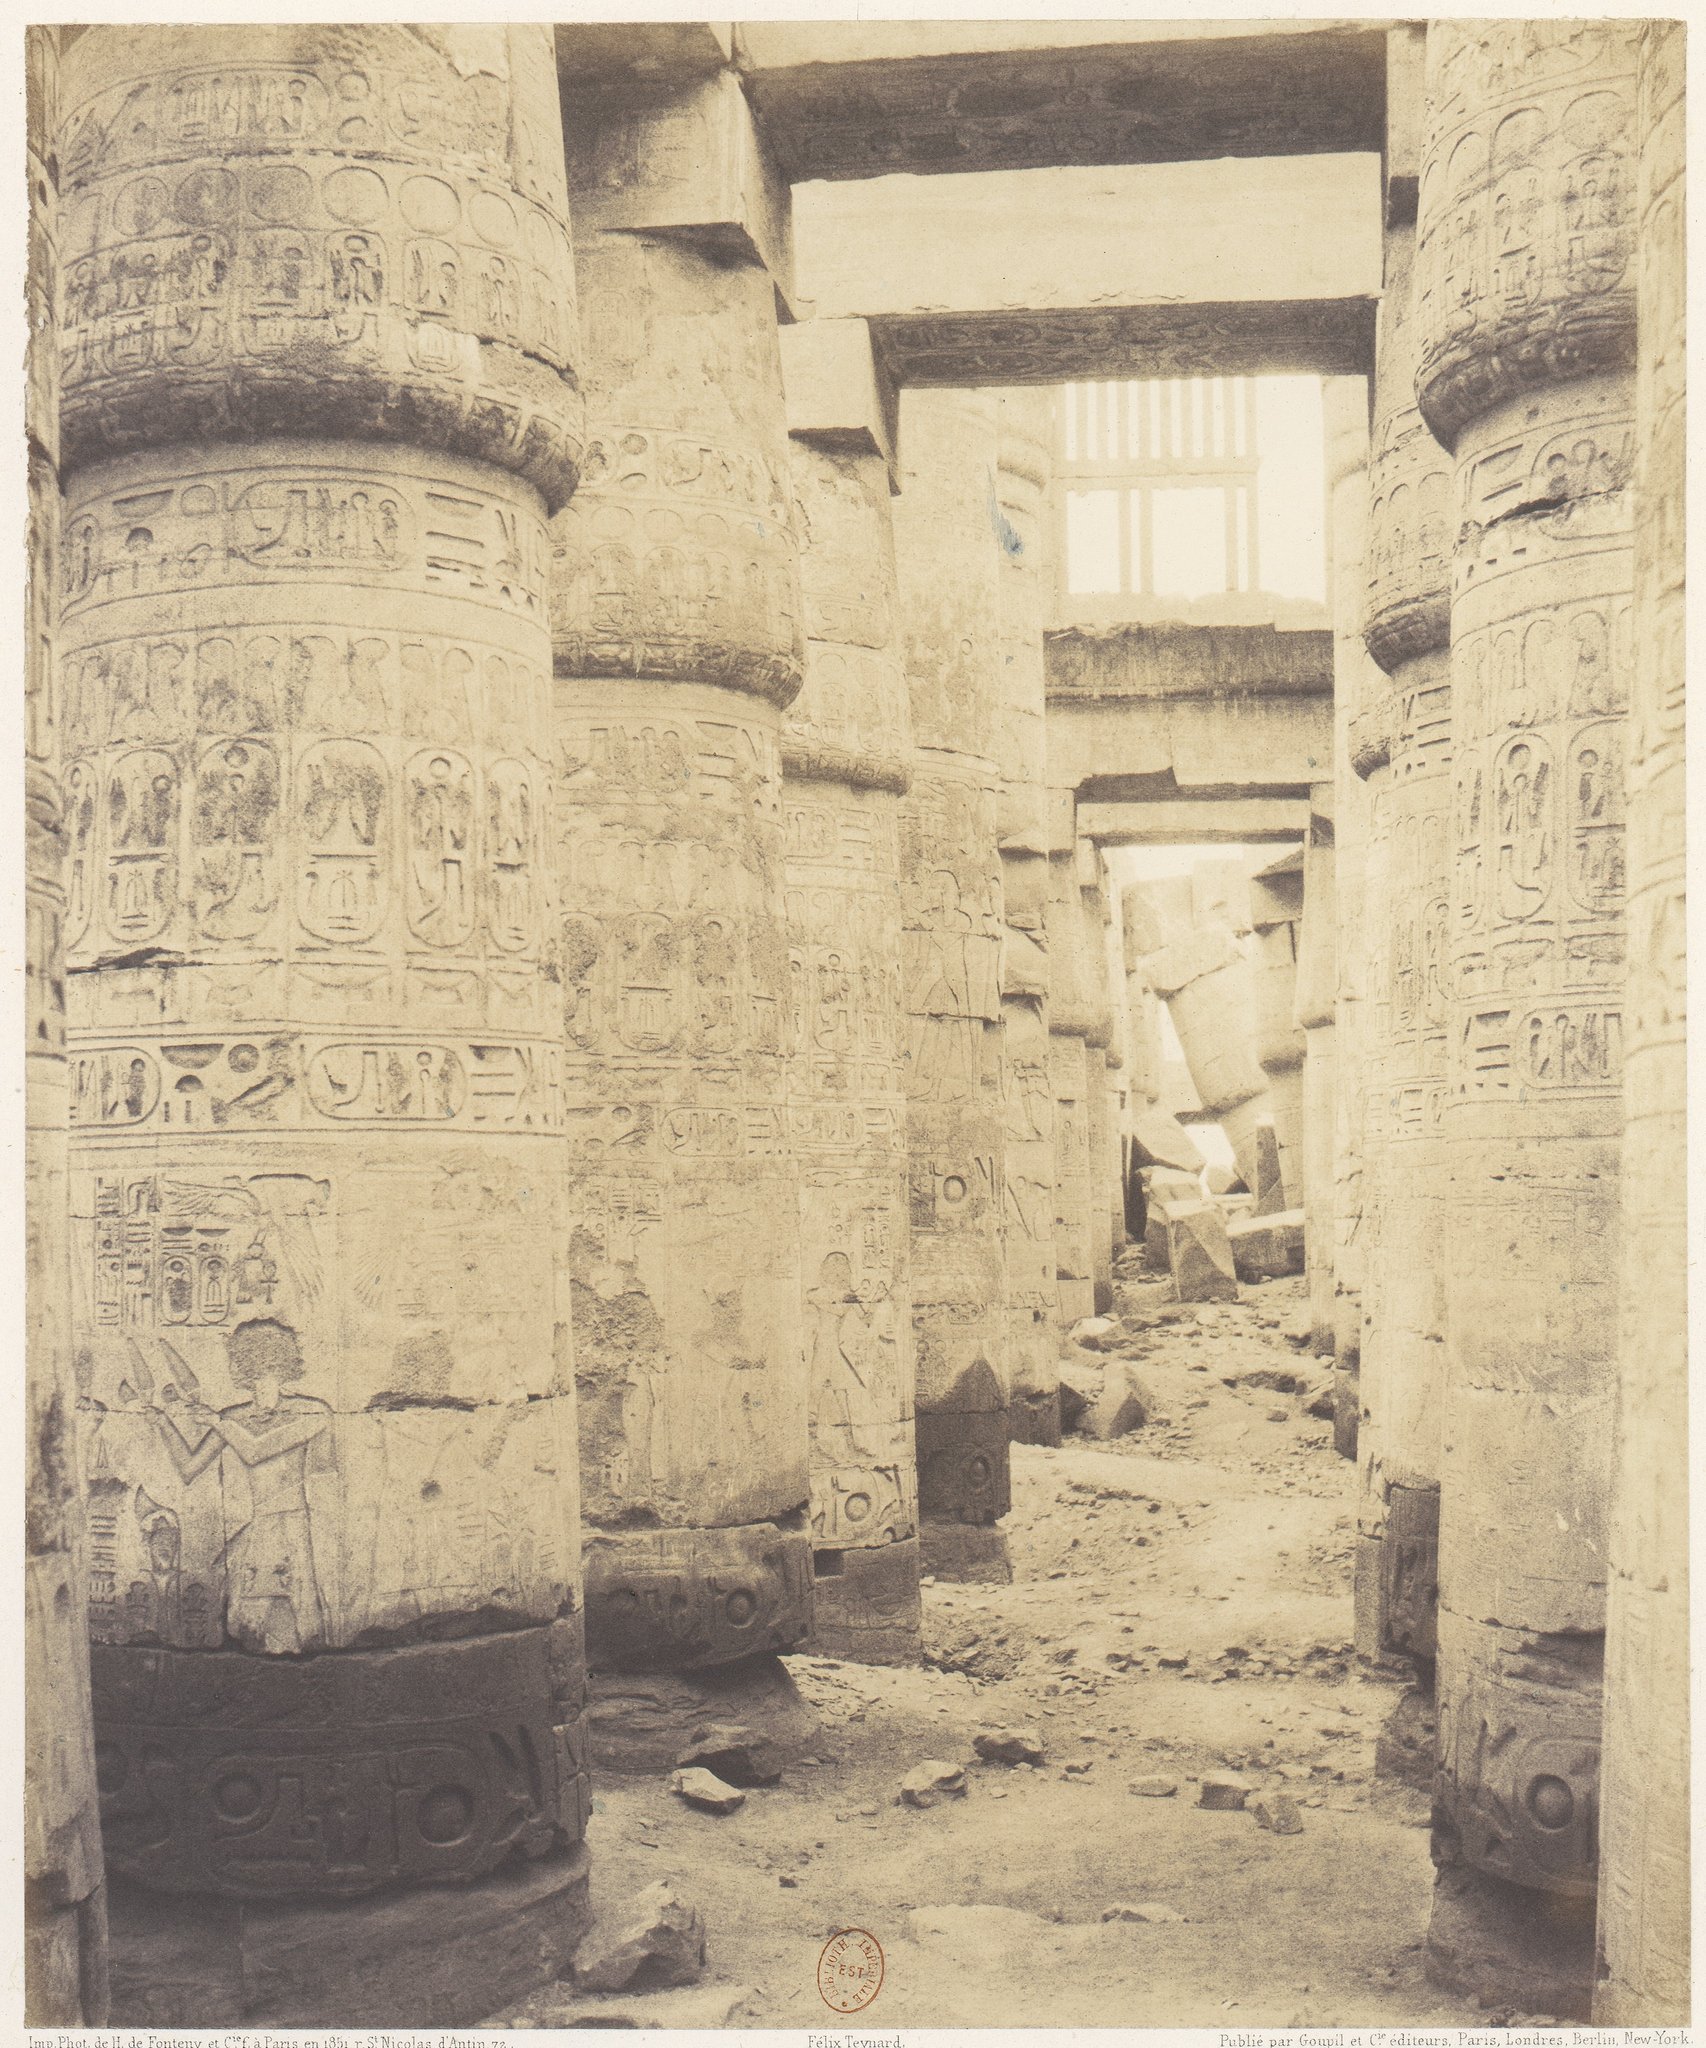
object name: photograph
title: Karnak (Thèbes), Palais - Salle Hypostyle - Fenêtre et Chapiteaux des Galleries Latérales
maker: félix teynard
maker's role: artist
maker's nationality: french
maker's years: 1817-1892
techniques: paper negative, salted paper print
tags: columns,ruins,hieroglyphs